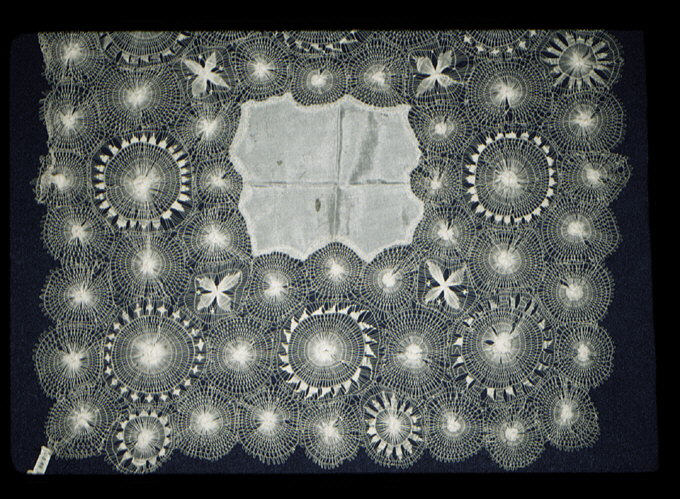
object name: handkerchief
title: Lace handkerchief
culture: paraguayan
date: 1801-1900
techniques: embroidery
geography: paraguay